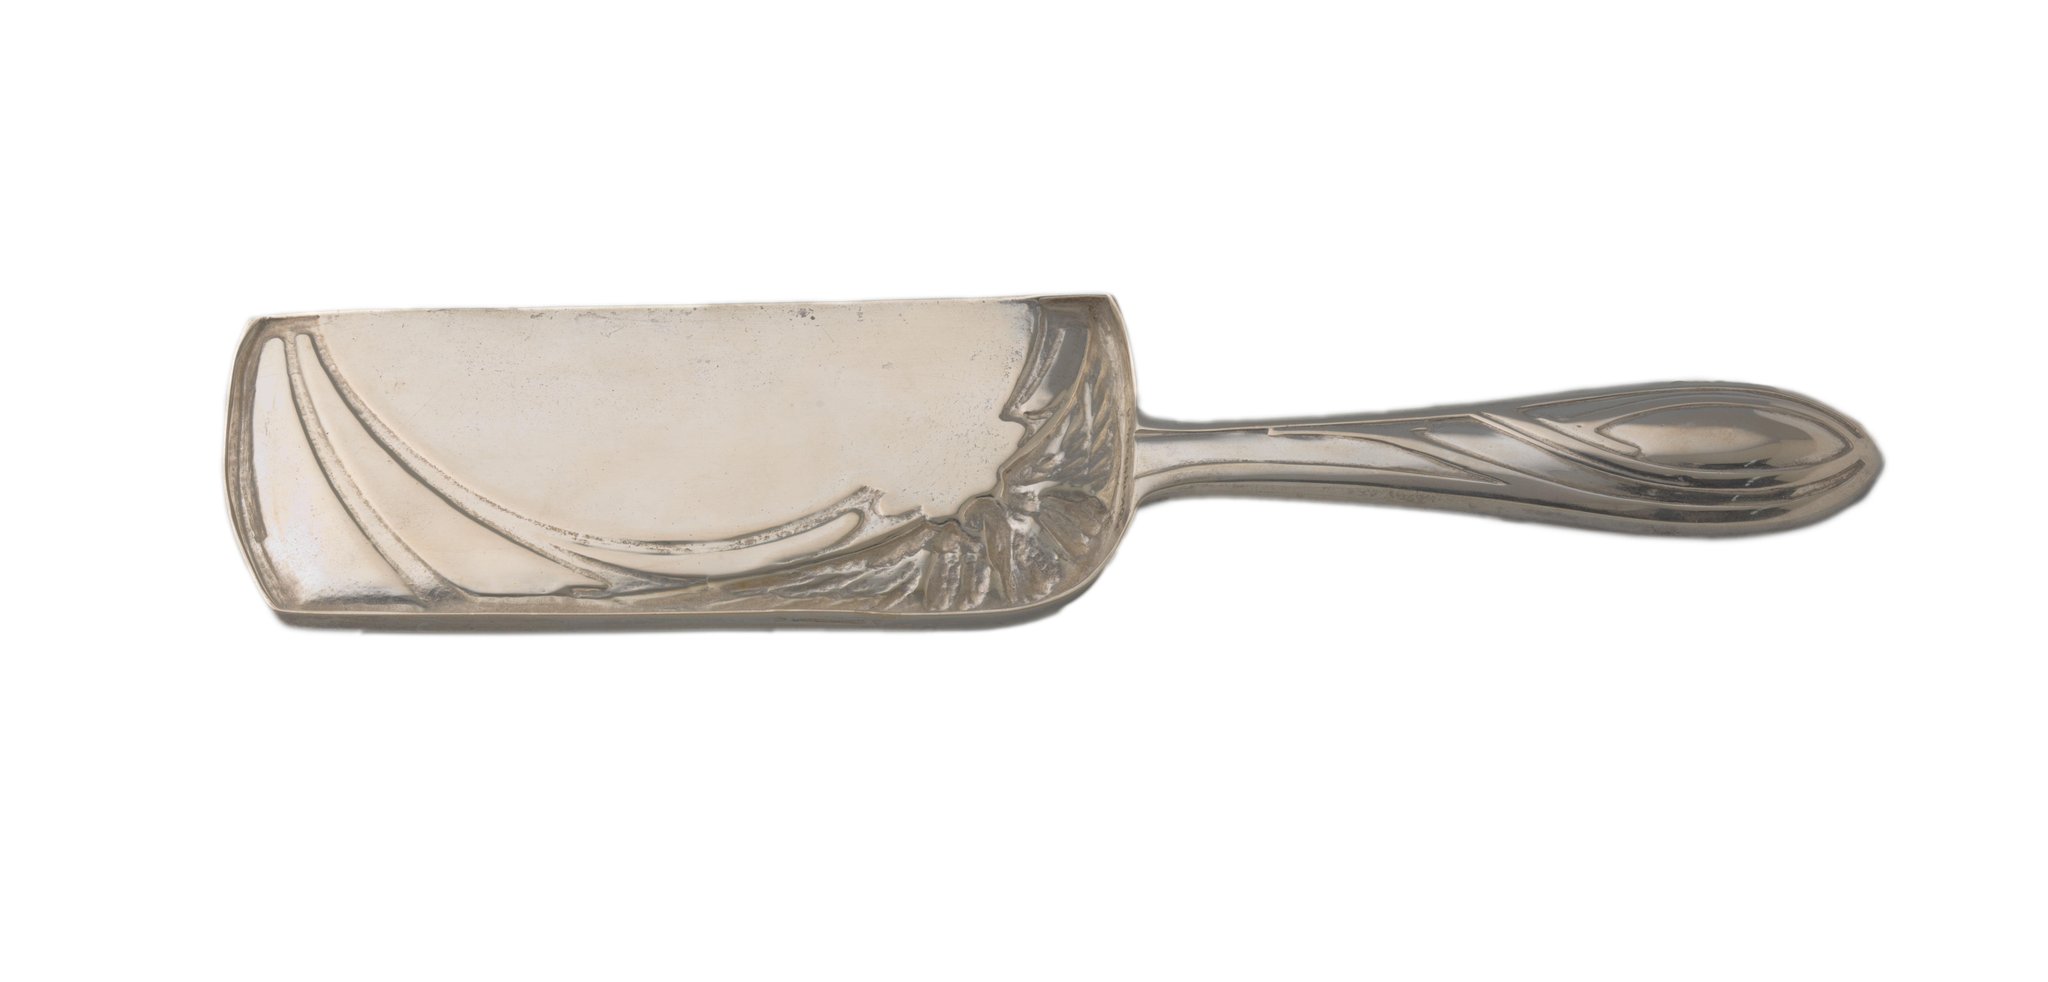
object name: crumber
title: Kruimelschuiver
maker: philippe wolfers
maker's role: designer, goldsmith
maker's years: 1858-1929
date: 1906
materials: silver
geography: brussels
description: Crumb-pan and brush. Silver. Brussels, c. 1900 - 1905, by Wolfers Frères, designed by Philippe Wolfers.